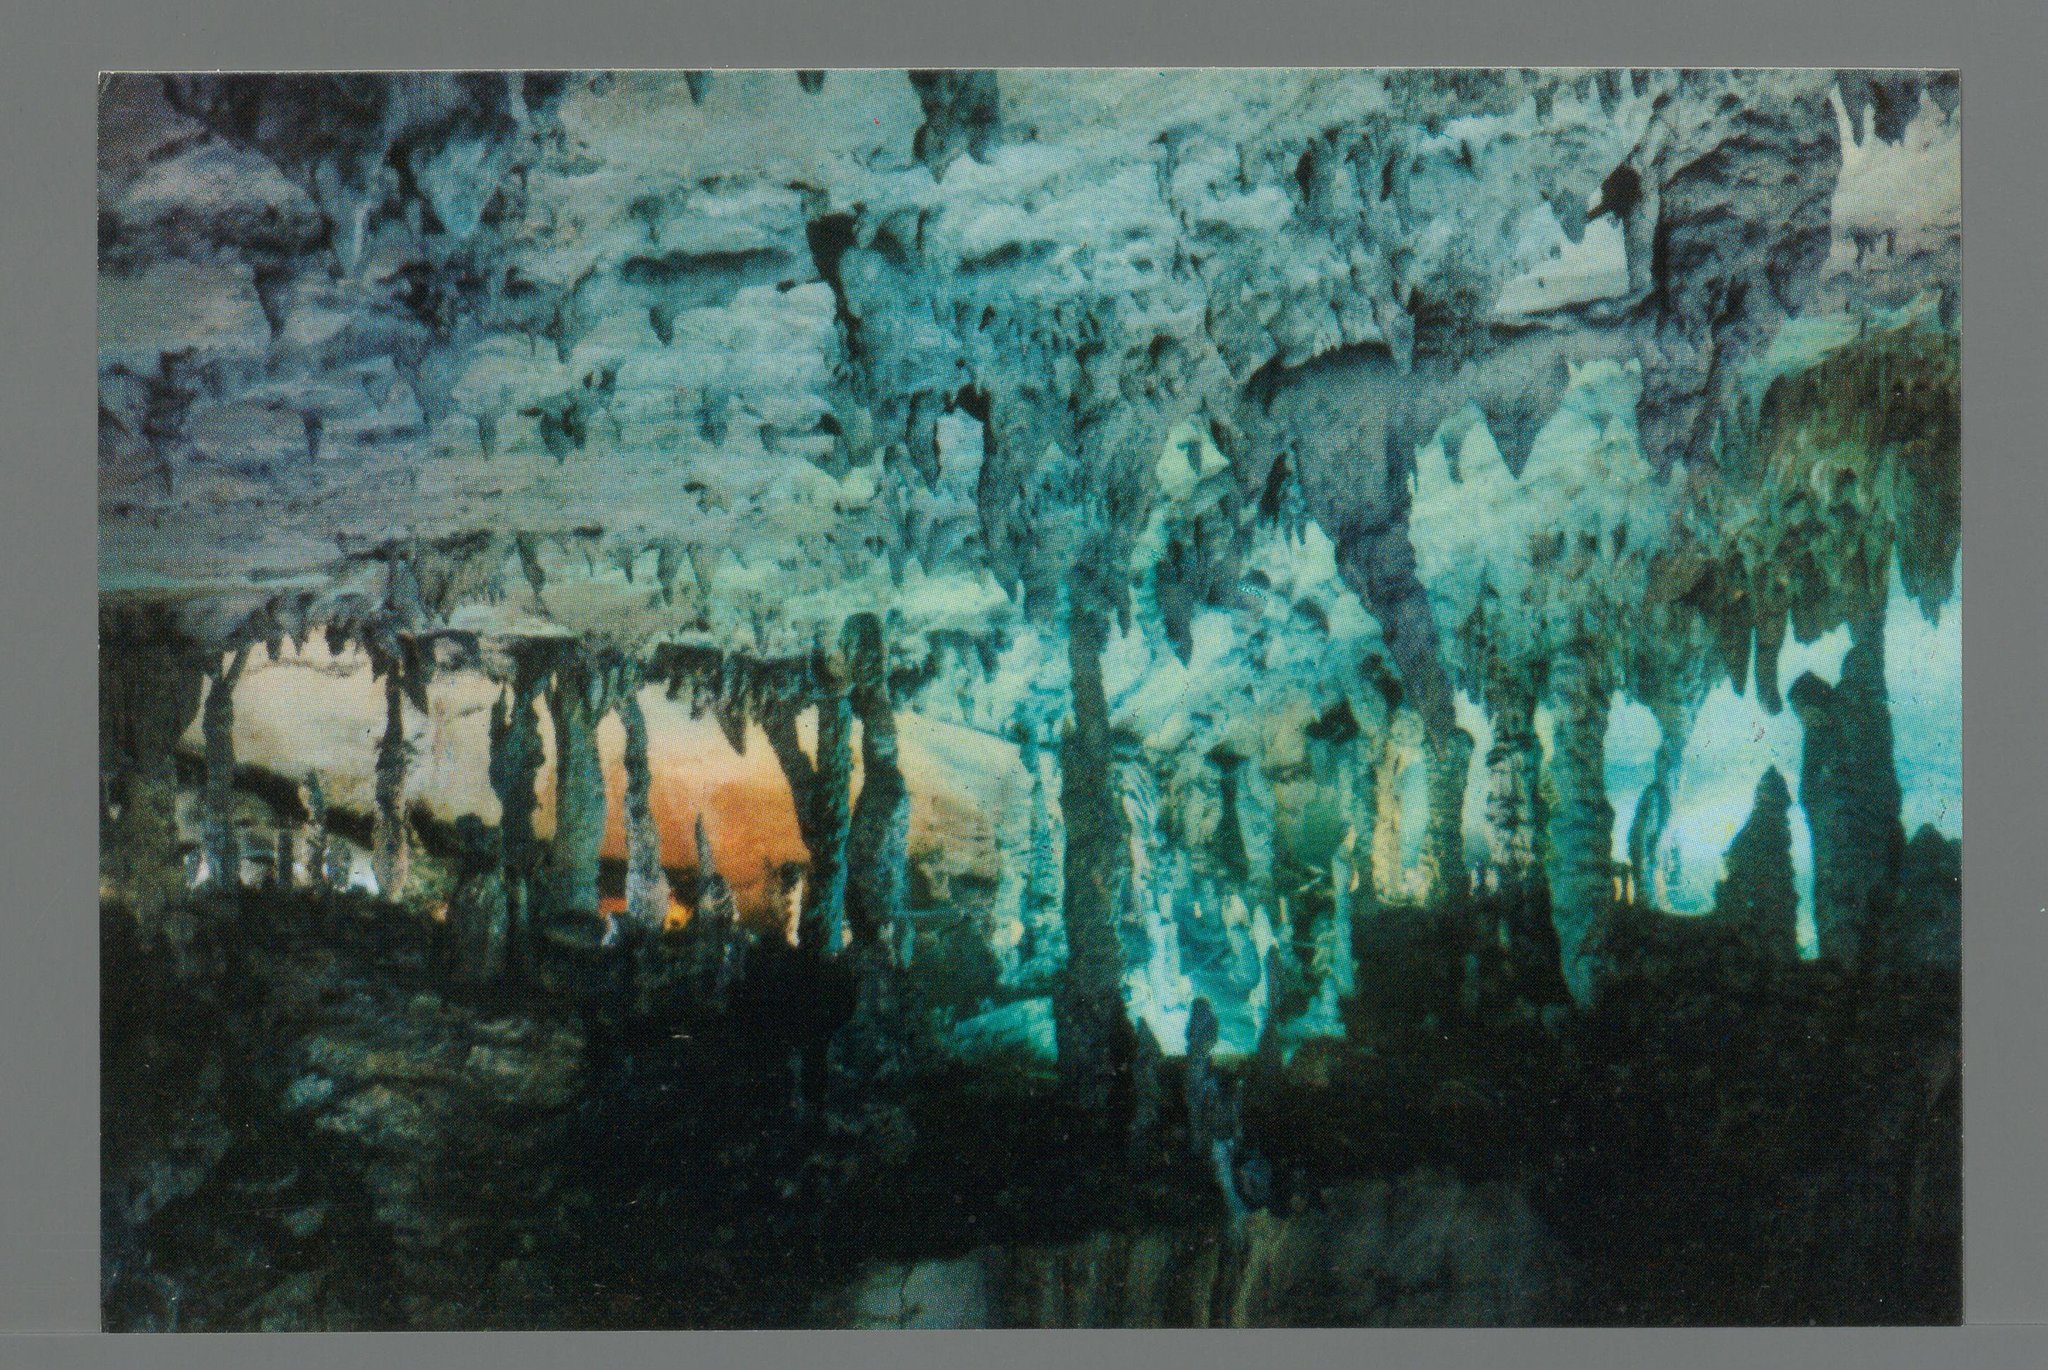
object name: ansichtkaart, prentbriefkaart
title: Dripstones in Seven Star Cavern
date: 1974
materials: cardboard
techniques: offset printed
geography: beijing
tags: stalactitic cave